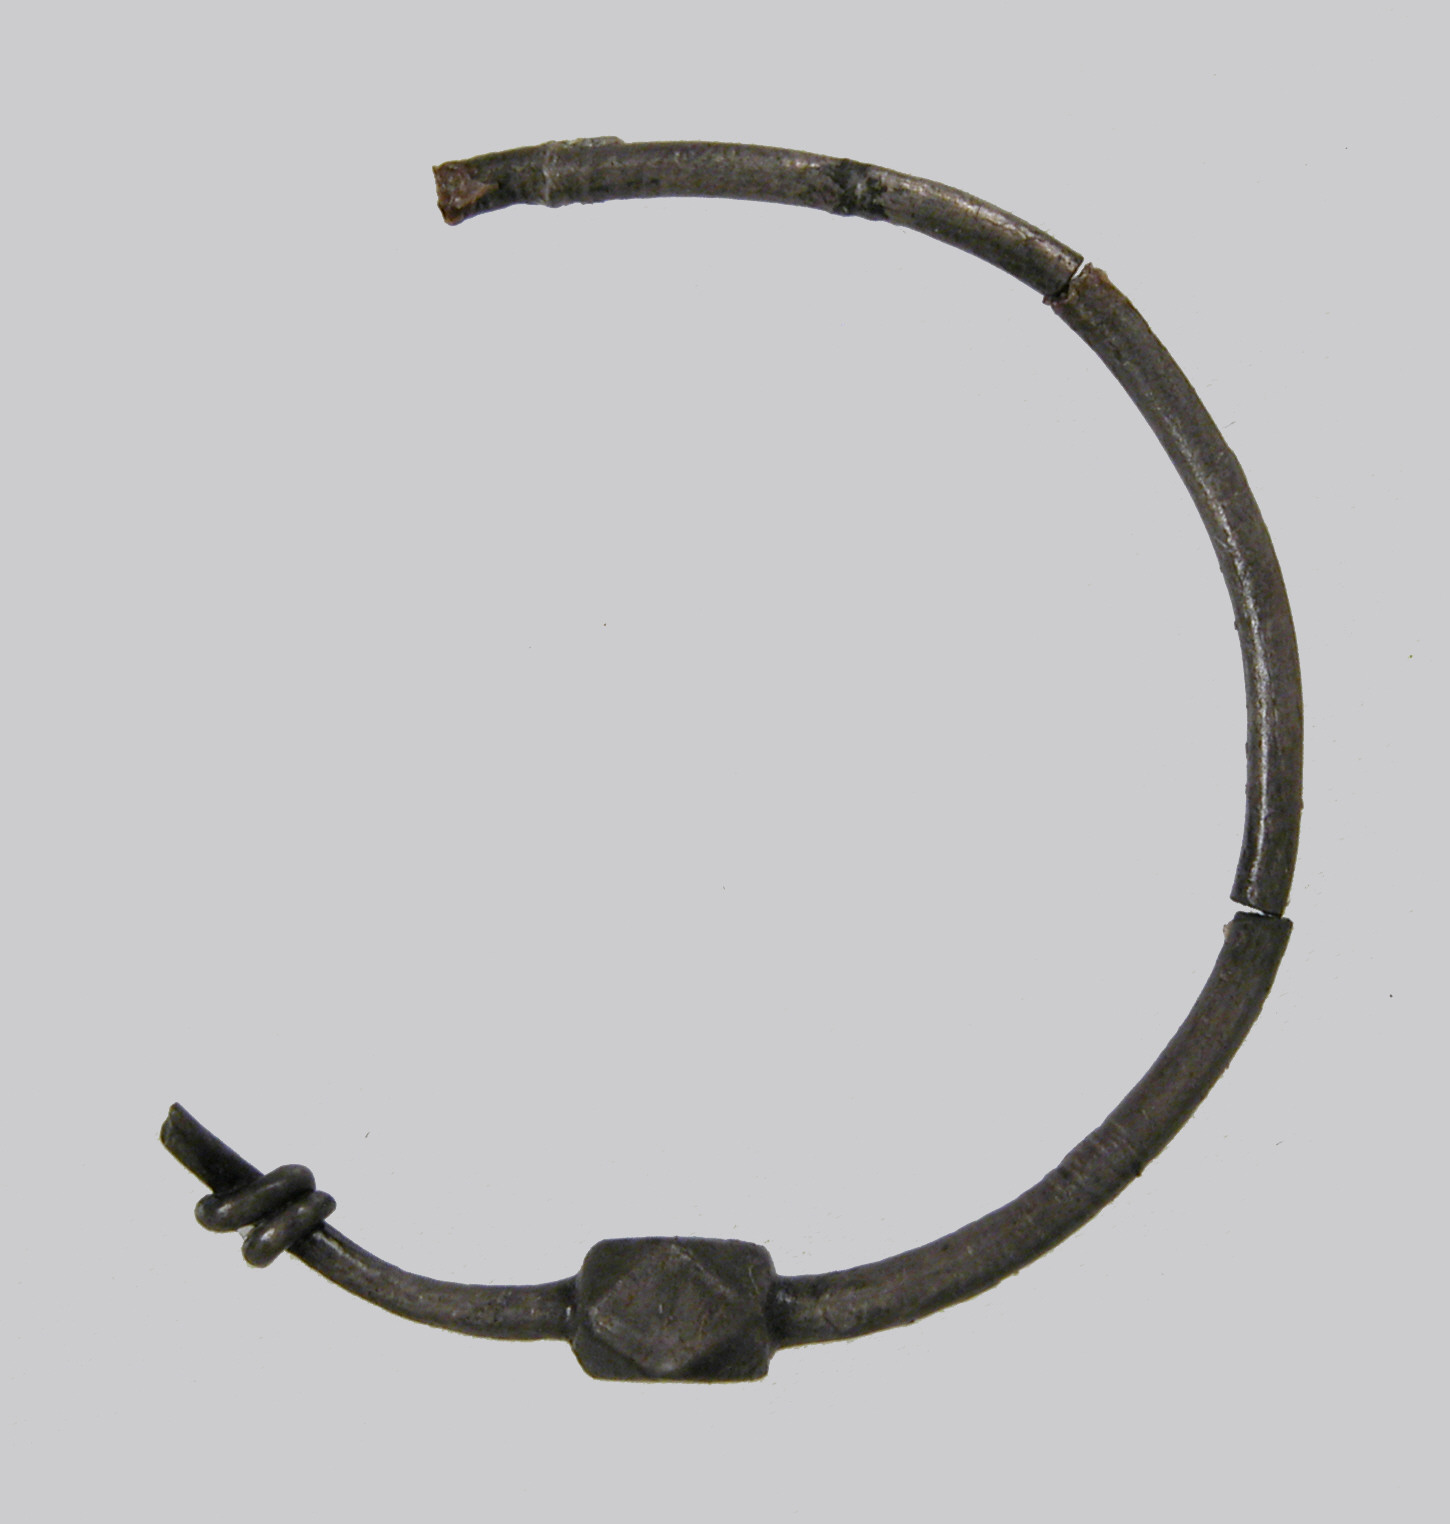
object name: earring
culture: frankish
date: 601-700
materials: silver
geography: germany